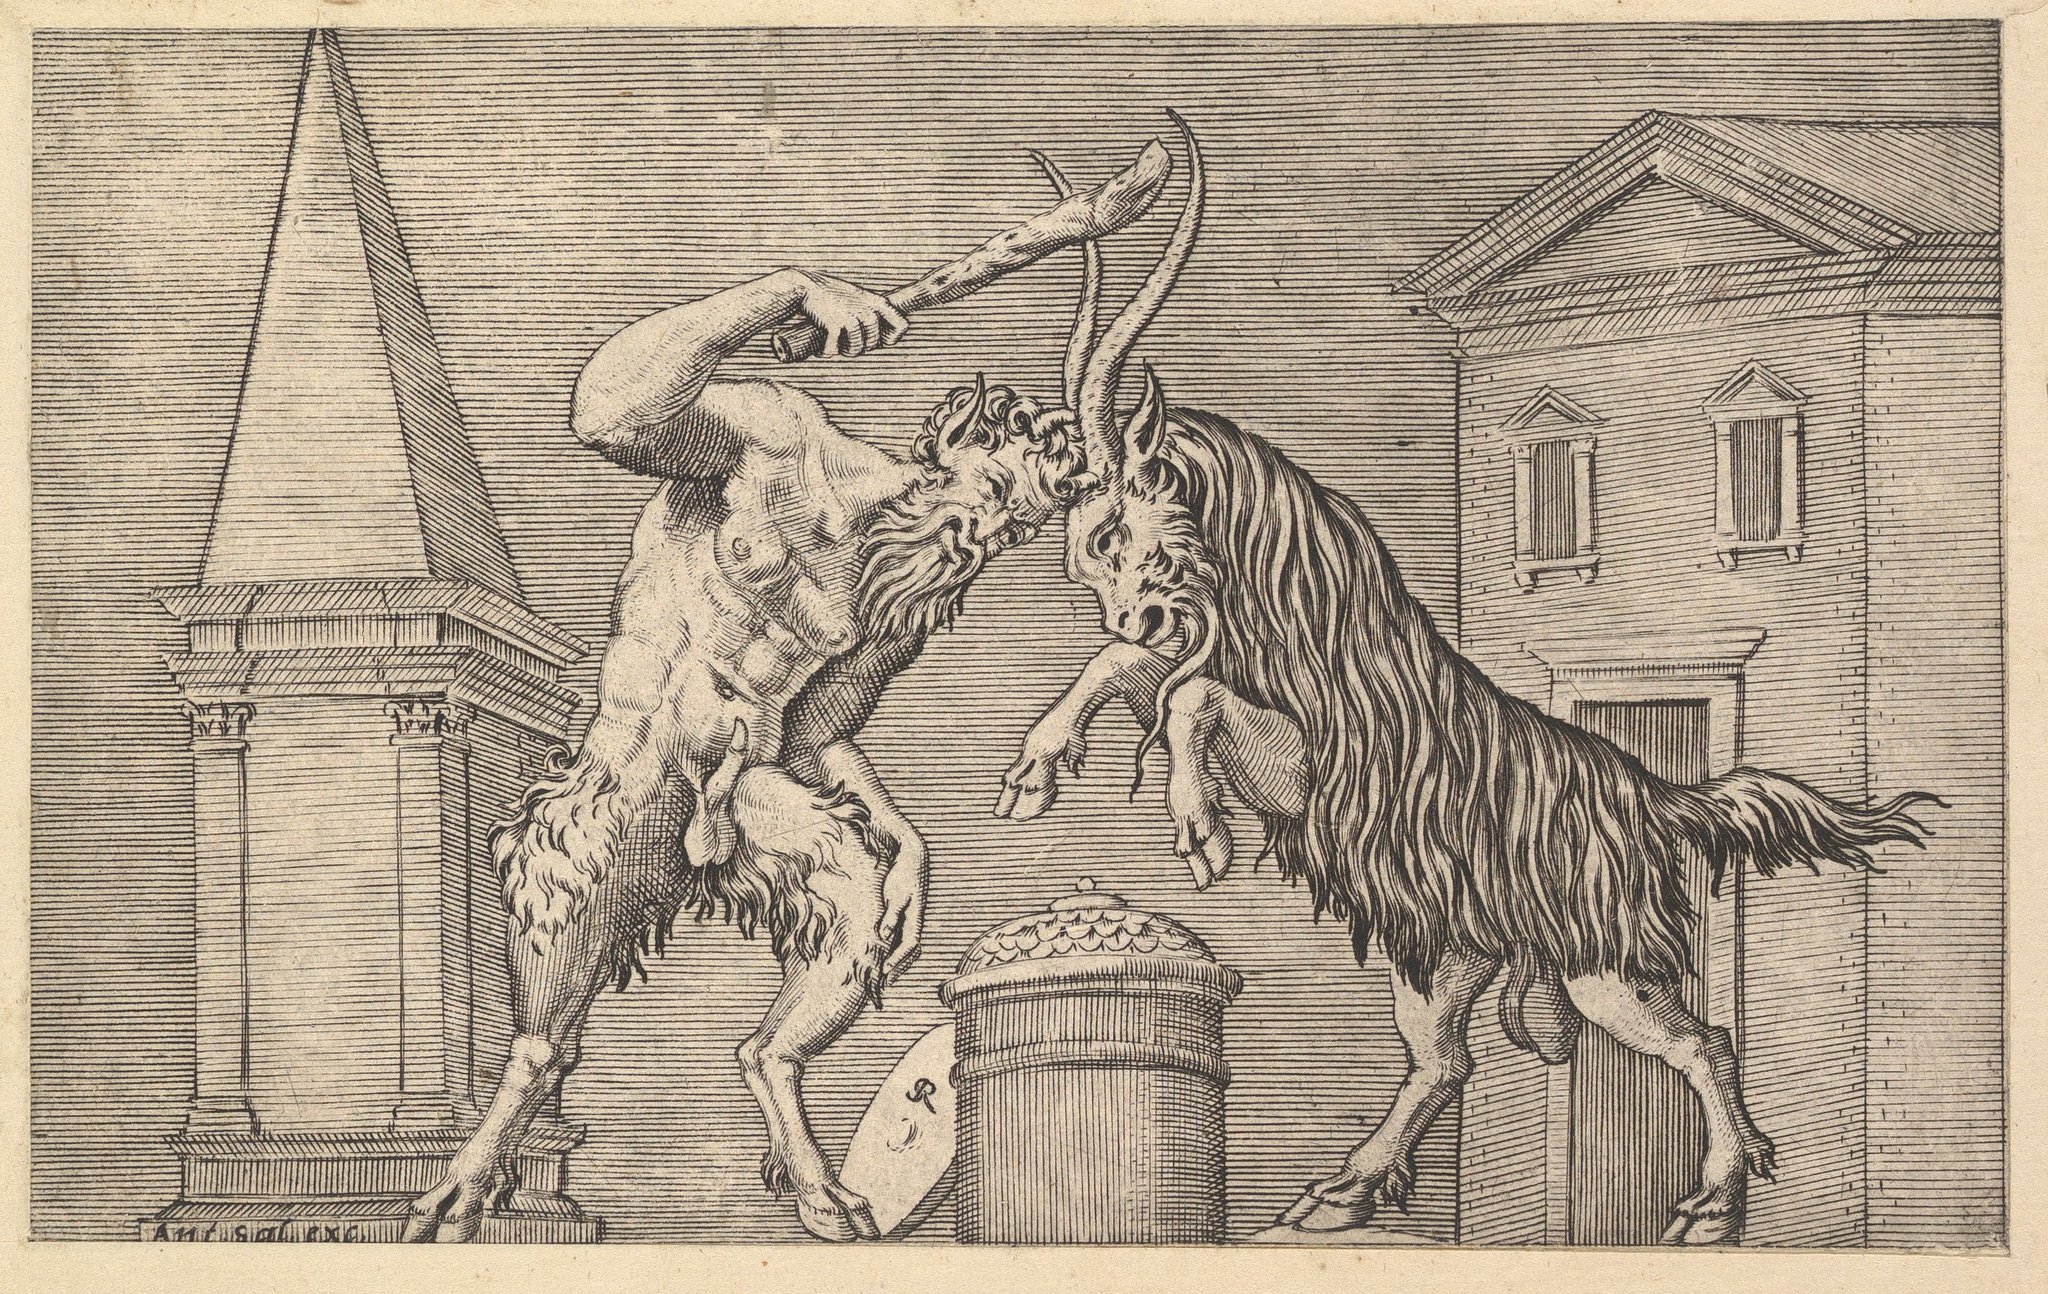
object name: print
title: A Satyr and a Ram Clashing, from "Speculum Romanae Magnificentiae"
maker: marco dente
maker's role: artist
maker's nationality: italian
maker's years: 1515-1527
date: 1501-1600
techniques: engraving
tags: satyrs,rams